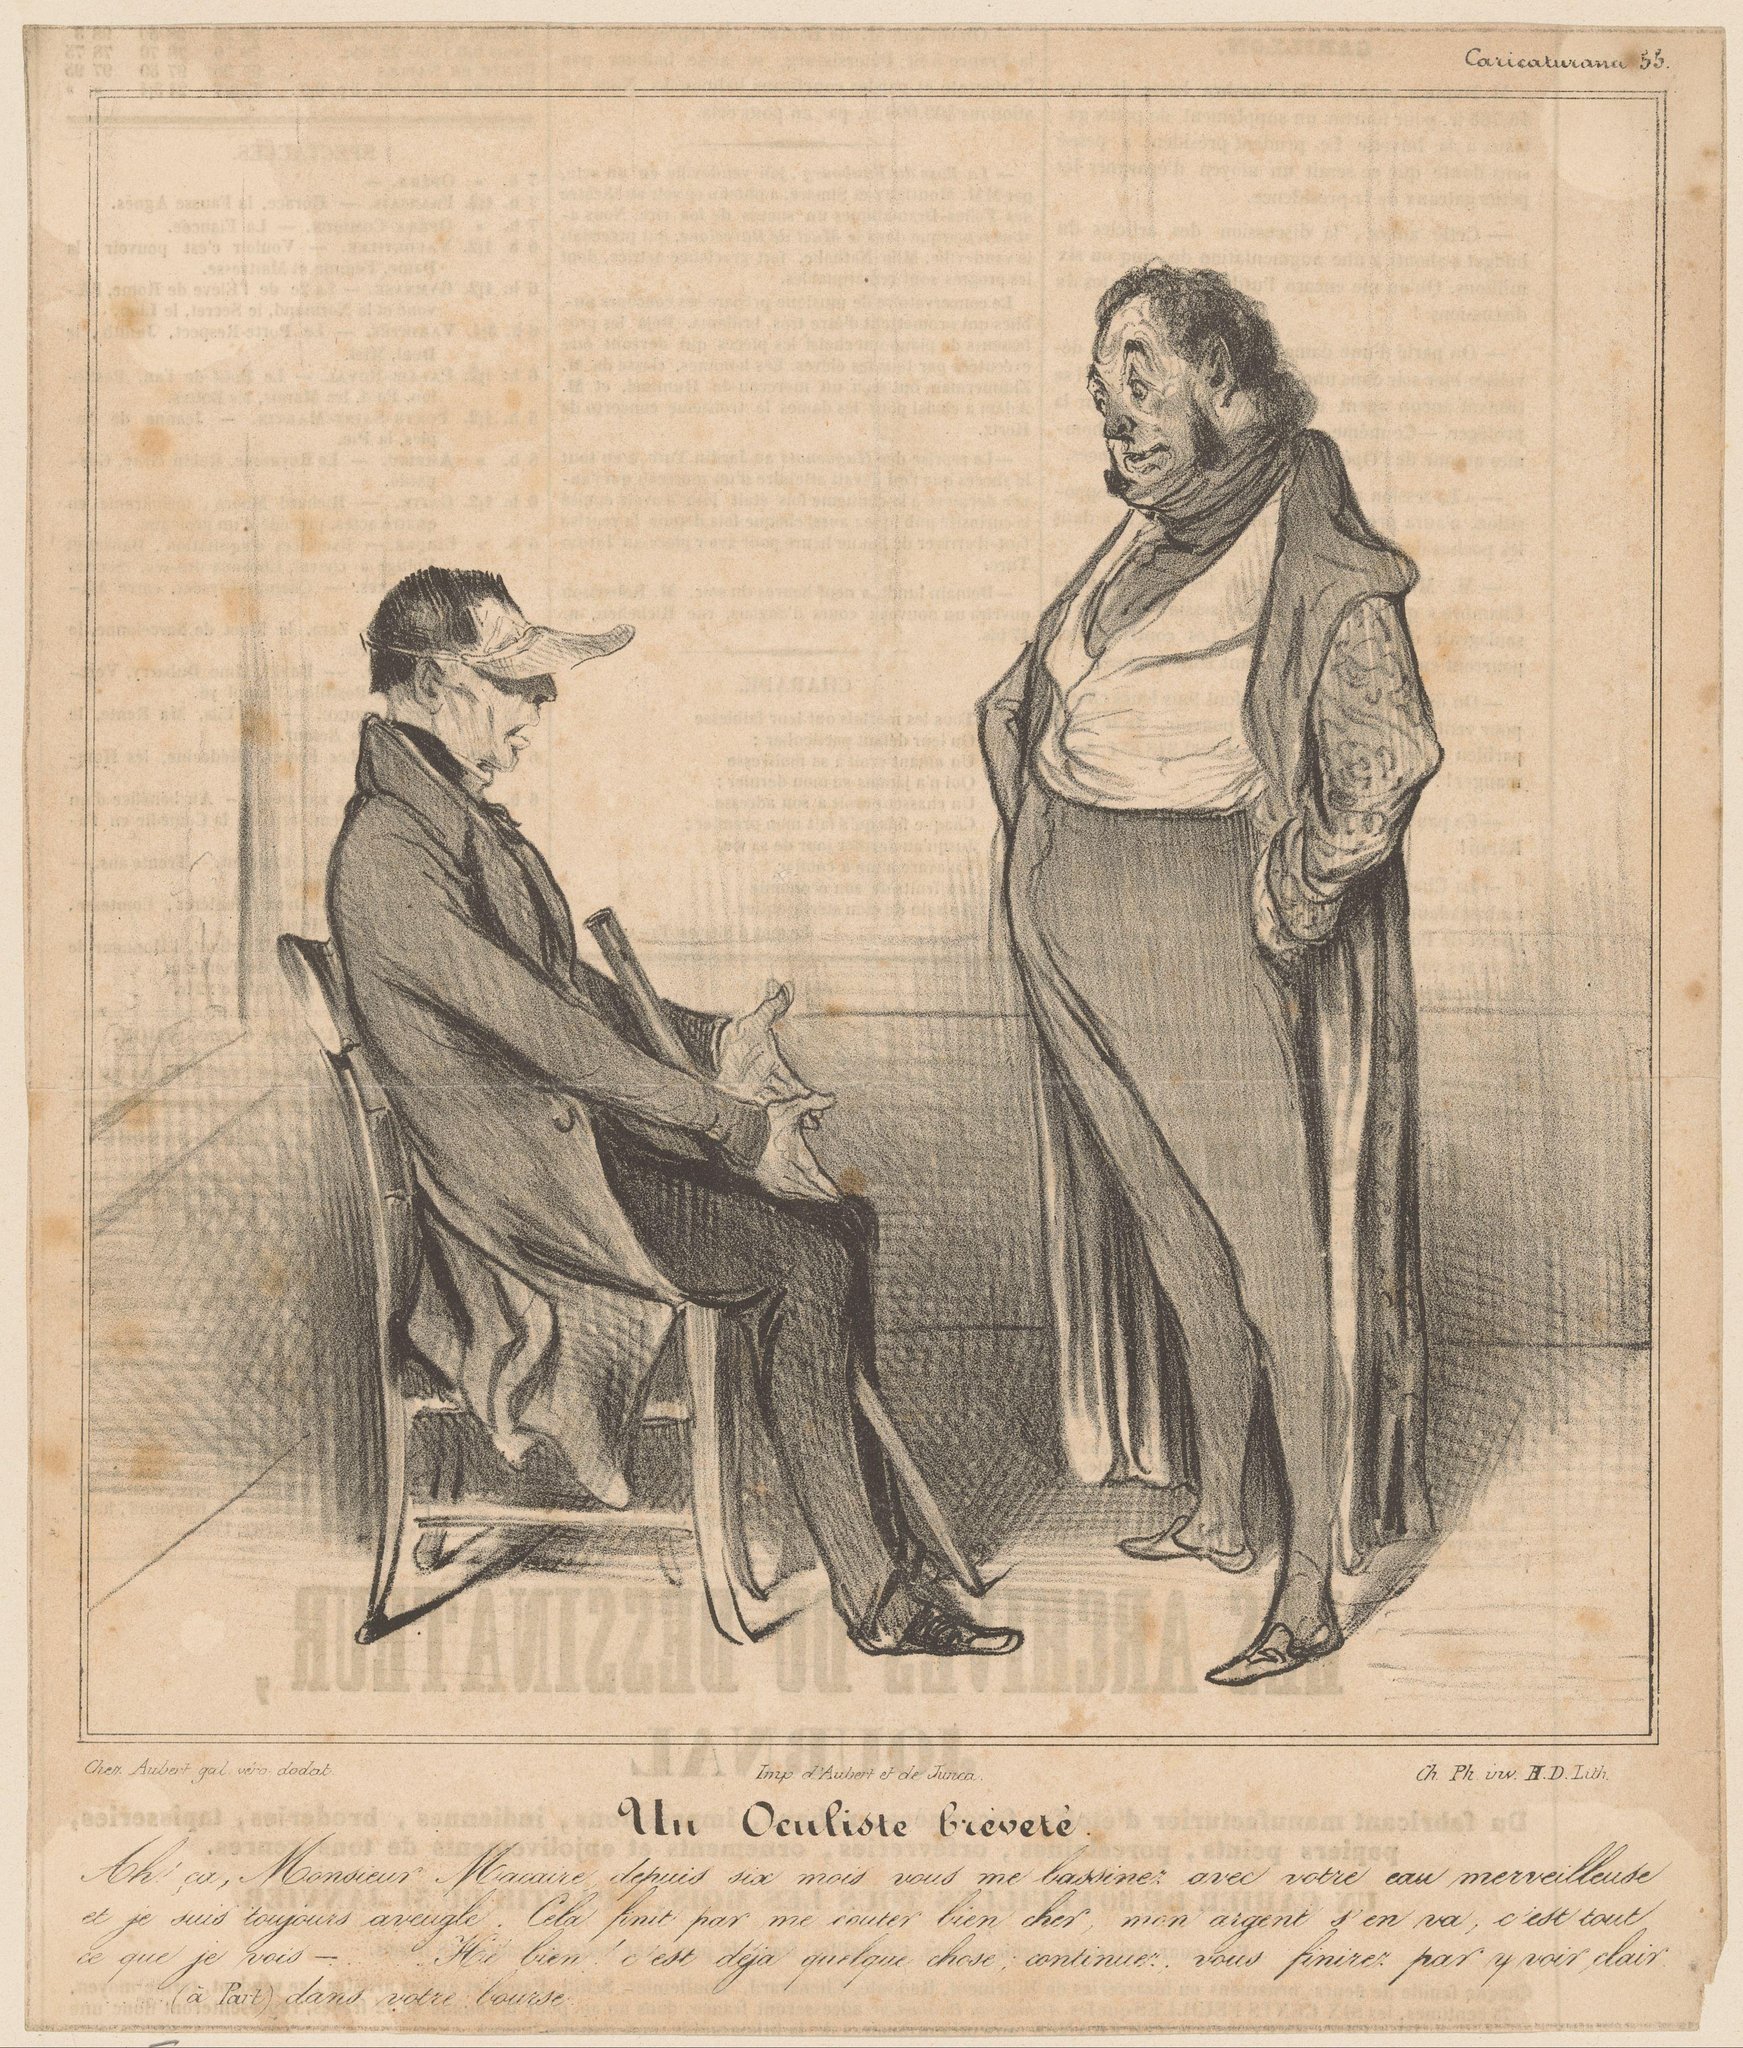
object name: cartoon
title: Un oculiste breveté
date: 1837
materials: paper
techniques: letterpress printing, lithograph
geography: paris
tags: caricatures (human types), ophthalmologist, blind, blindness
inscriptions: collector's mark: Lugt 2228a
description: Prent mogelijk uit: Le Charivari, 2 juli 1837.